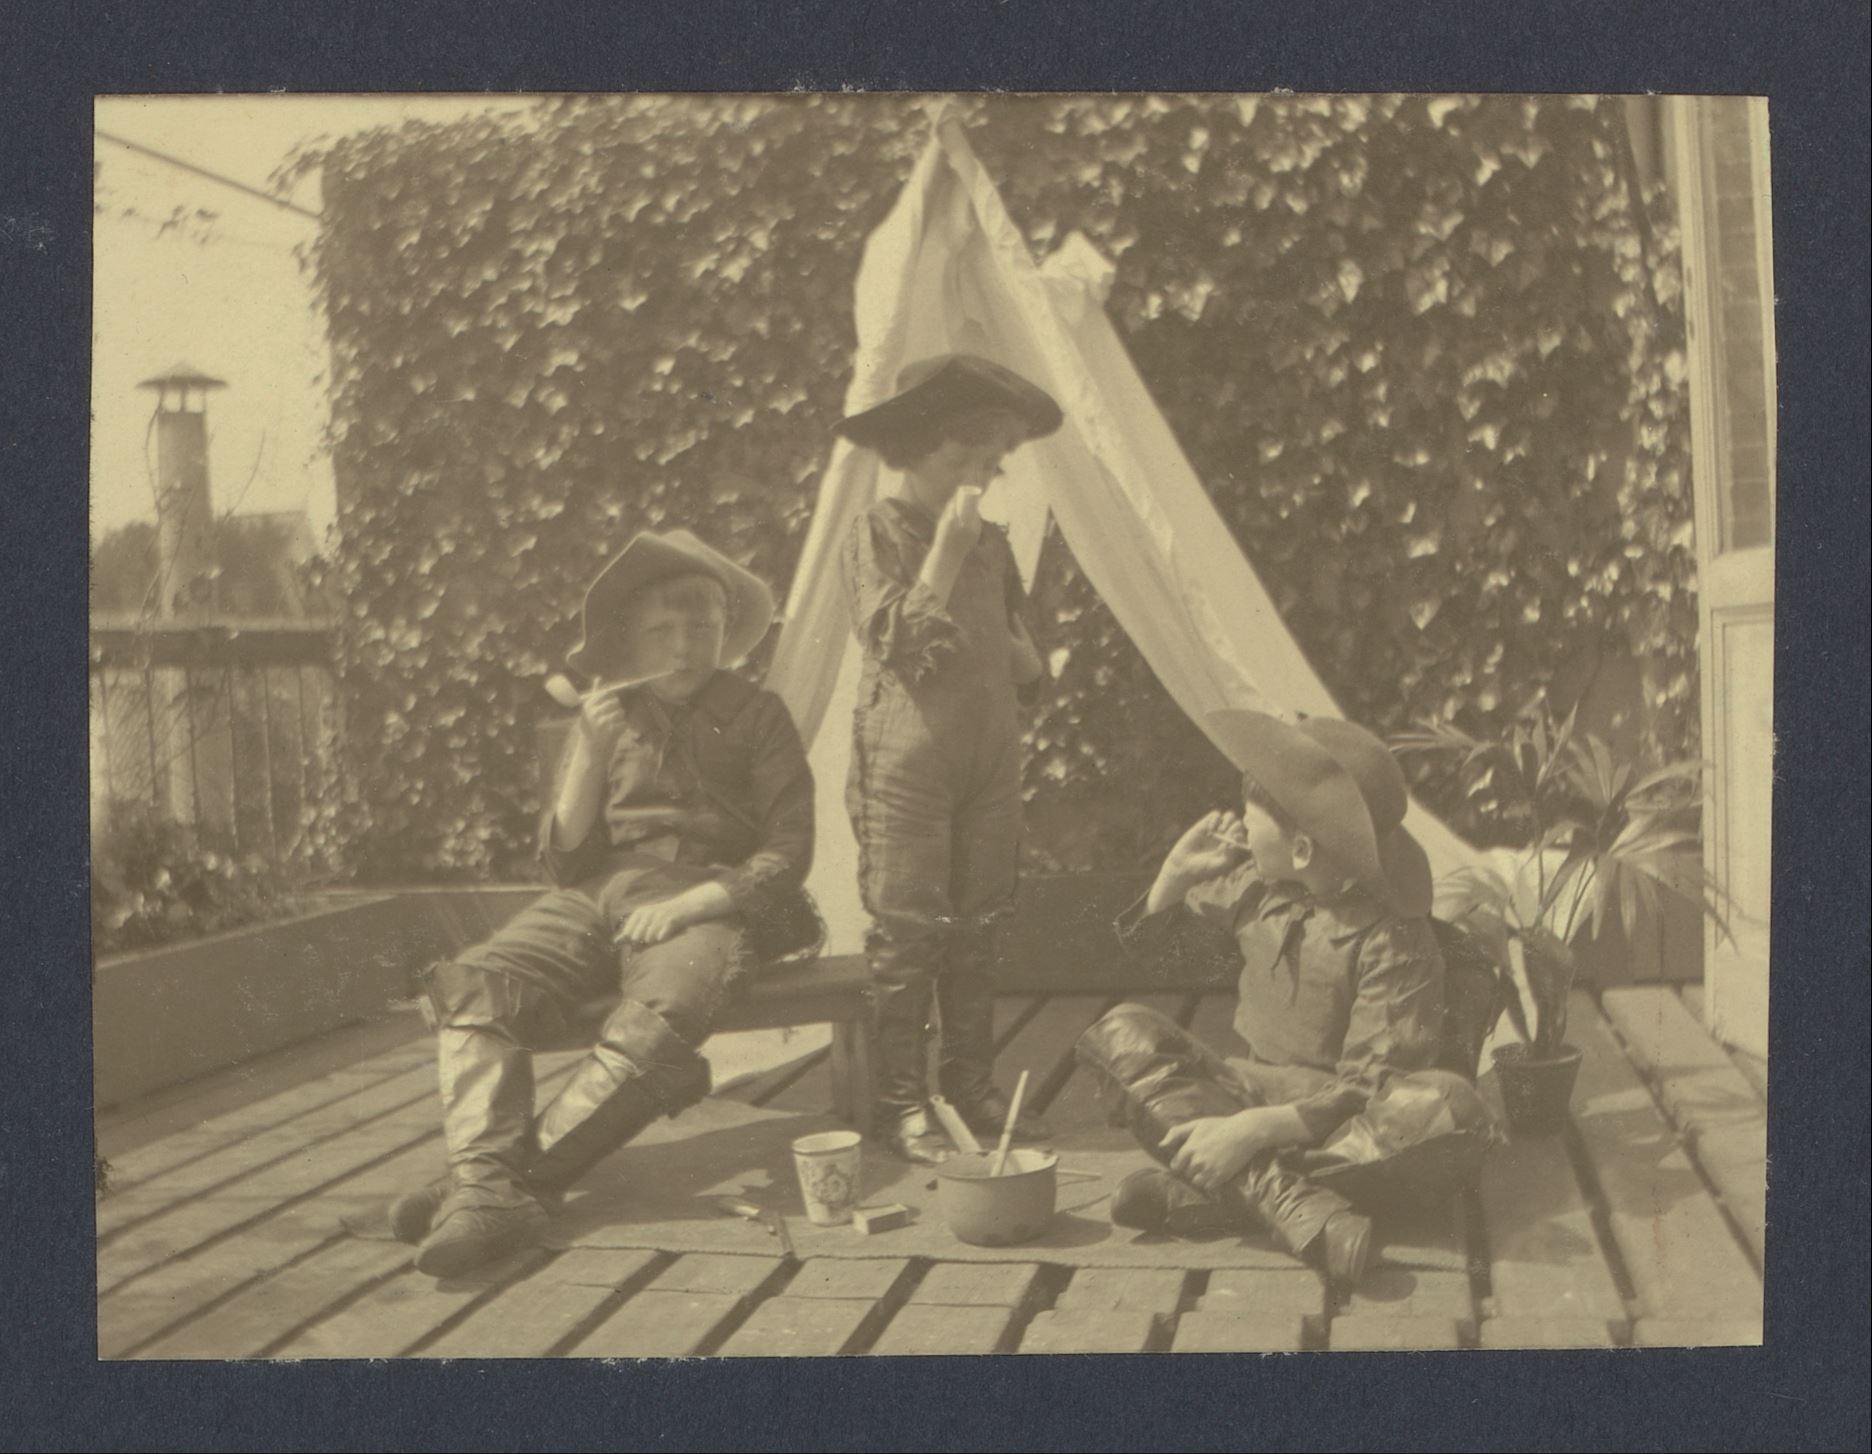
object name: photograph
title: Drie jongens in verkleedkleren spelen in een zelfgemaakte tent op het balkon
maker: cornelis johannes lodewicus vermeulen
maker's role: fotograaf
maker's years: 1861-1936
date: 1910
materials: photographic support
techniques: gelatin silver print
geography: the hague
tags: child, family life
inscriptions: annotation: ‘Gerard/ Gerrit/ Johann/ +_ 1910’